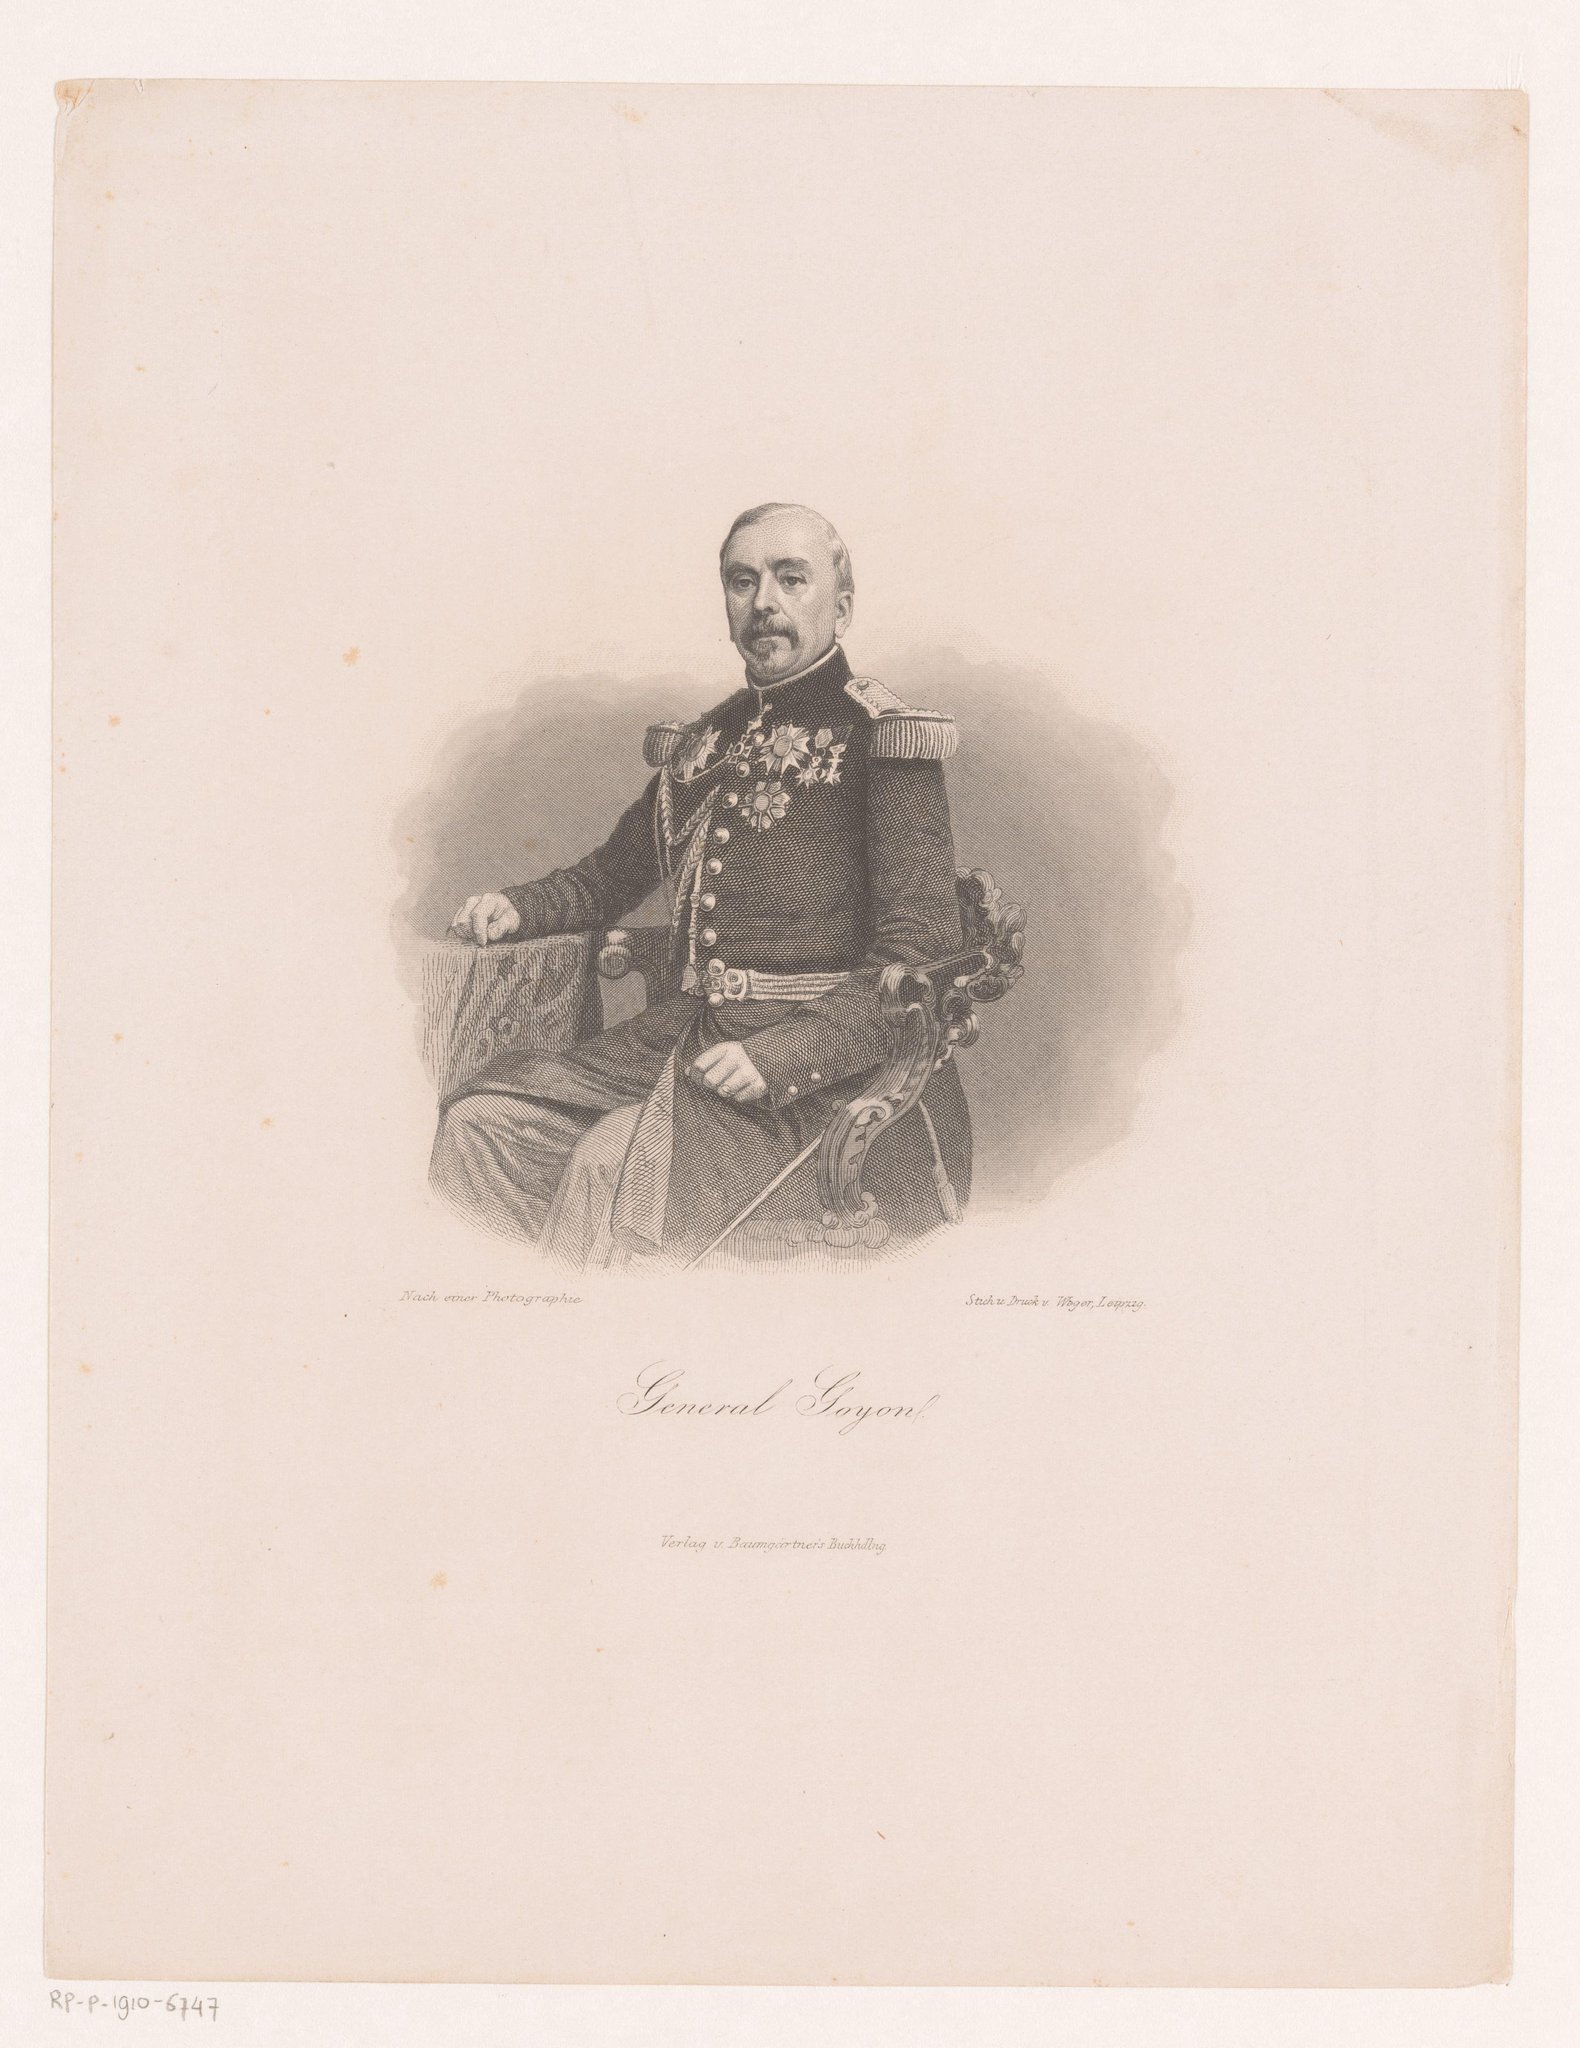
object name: print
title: Portret van Charles-Marie-Augustin de Goyon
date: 1849-1892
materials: paper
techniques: engraving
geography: leipzig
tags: paris, politician, historical persons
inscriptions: collector's mark: Lugt 2228